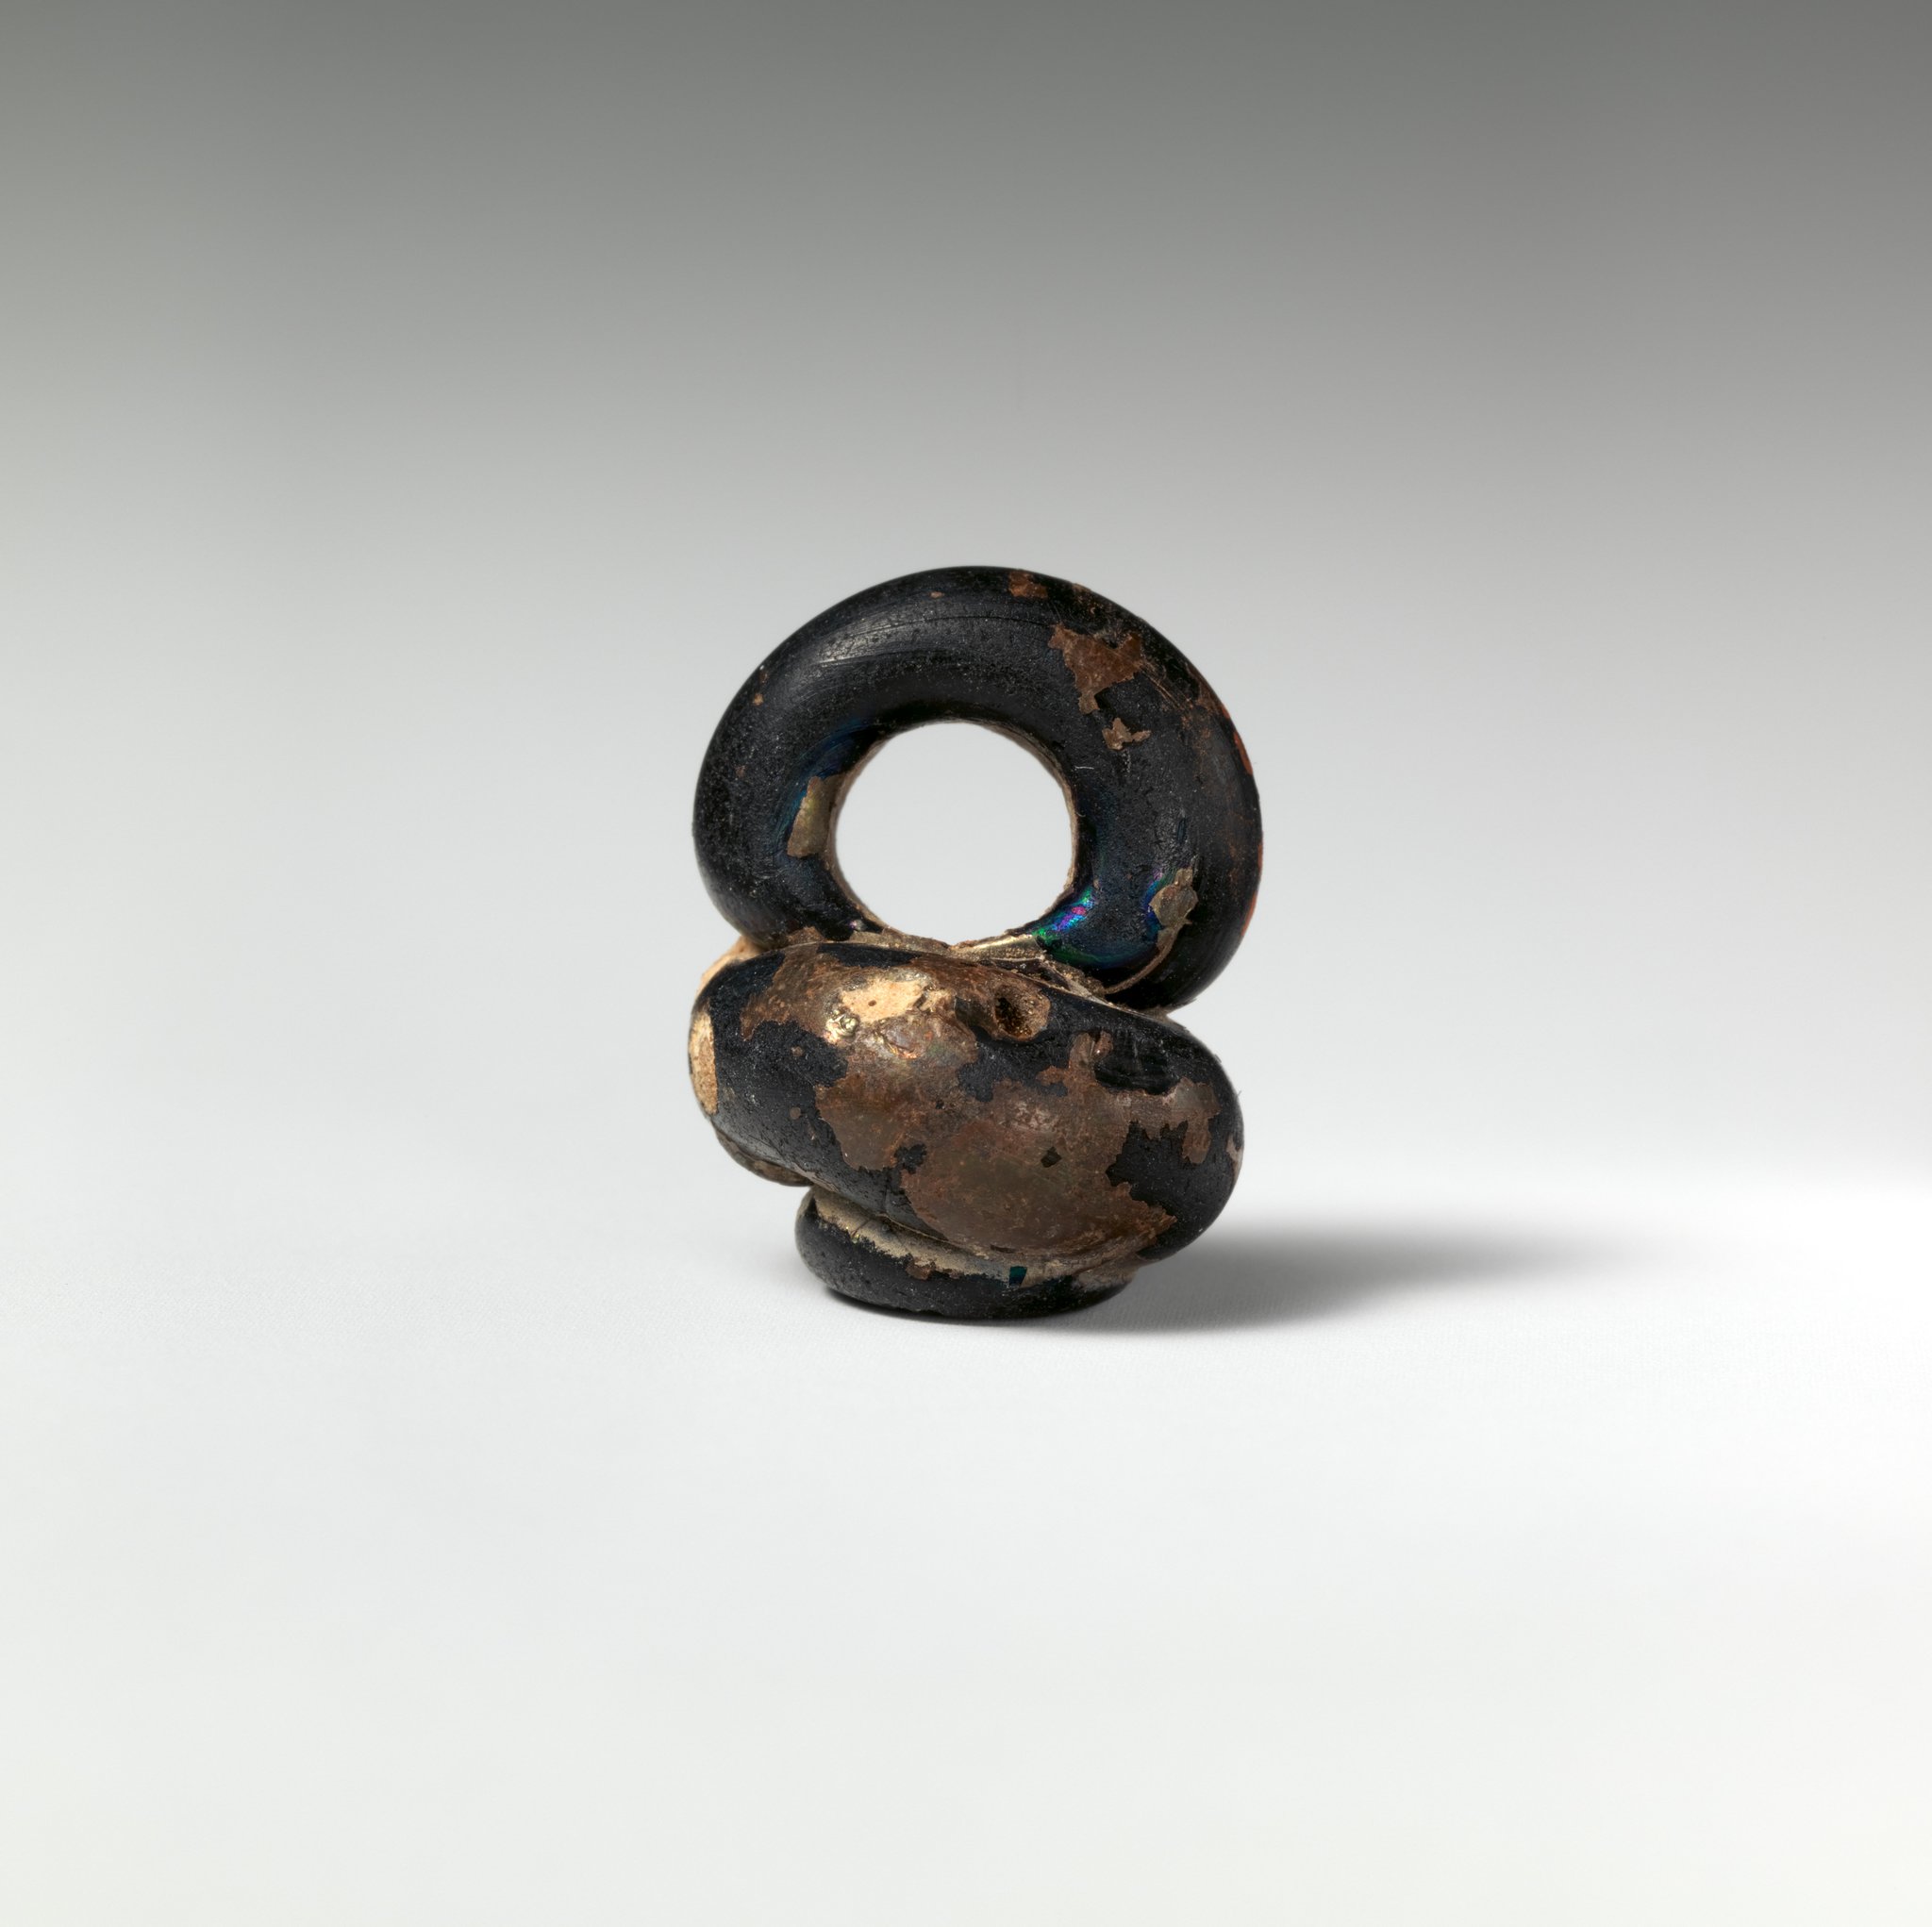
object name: pendant in the form of a jar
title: Glass pendant in the form of a miniature jar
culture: roman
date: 267-400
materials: glass